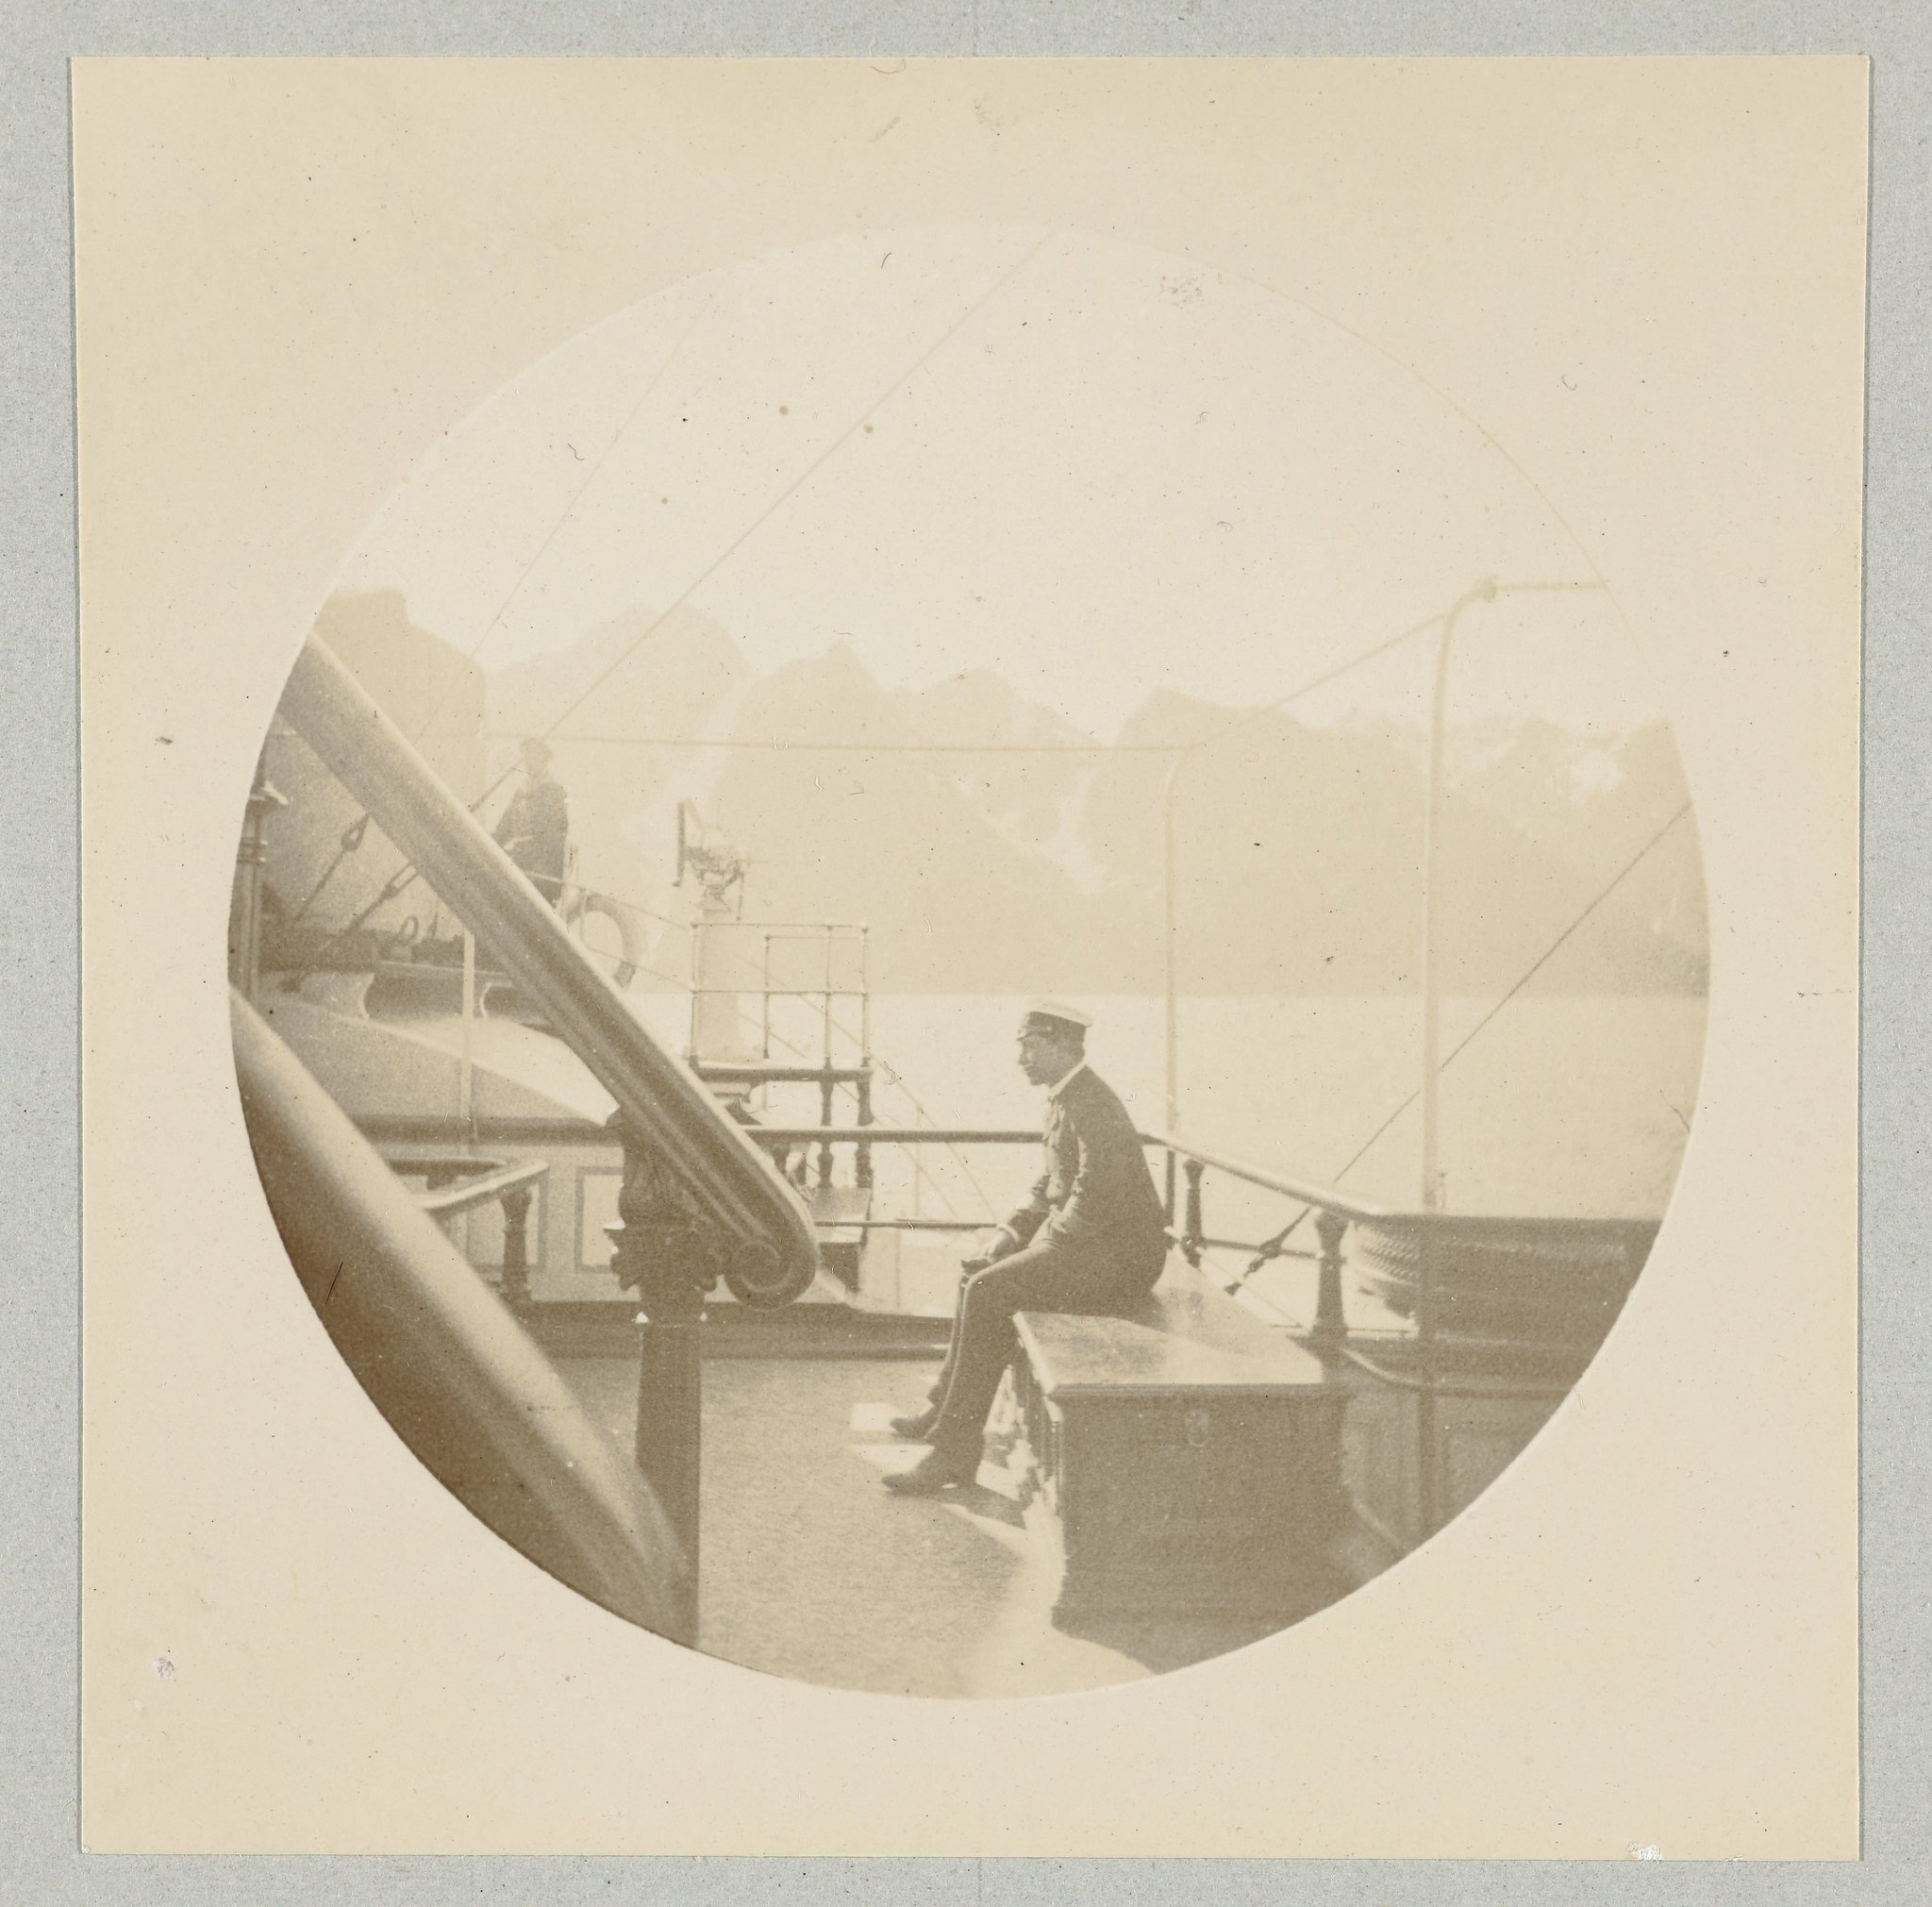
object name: photograph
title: Kapitein op het bovendek van de Hohenzollern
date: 1807-1889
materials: cardboard, paper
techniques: gelatin silver print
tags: wilhelm ii (keizer van duitsland), norway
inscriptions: number: ‘32’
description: De afdruk van de foto is rond, het papier vierkant. foto gemaakt met Nr. 1 Kodak Camera